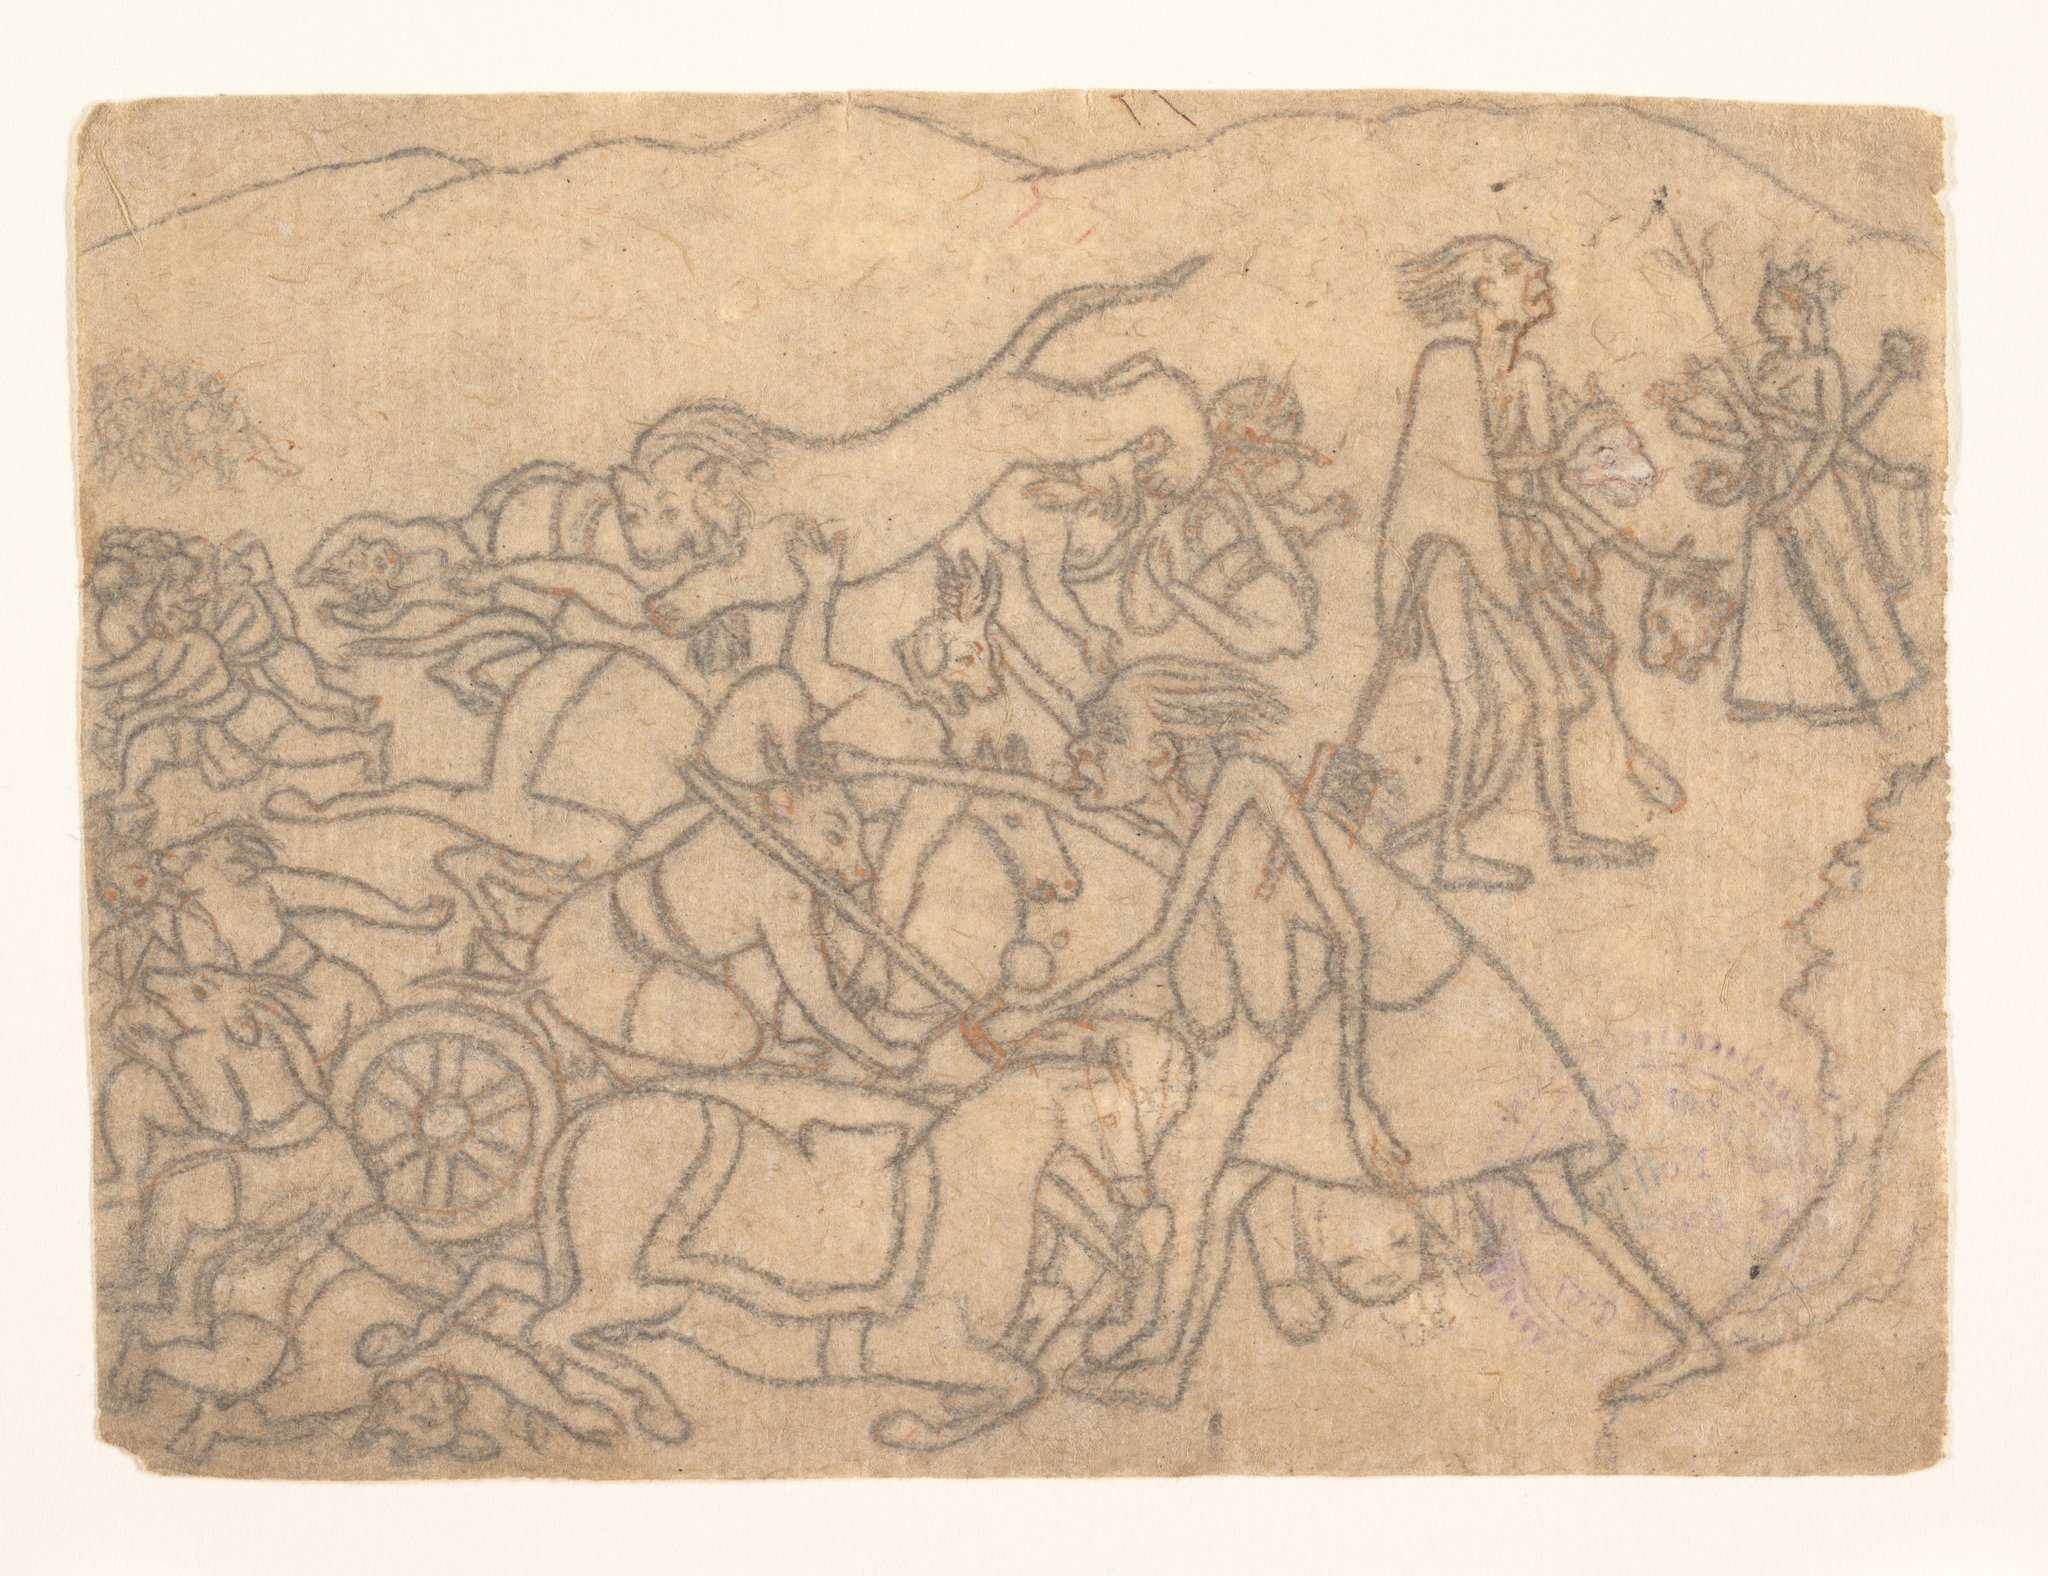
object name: drawing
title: Kali Presenting the Heads of Chanda and Munda to Durga: Scene from the Devi Mahatmya (Glory of the Goddess)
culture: indian, guler, himachal pradesh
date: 1780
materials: graphite, ink, paper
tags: battles,horses,lions,durga,hinduism